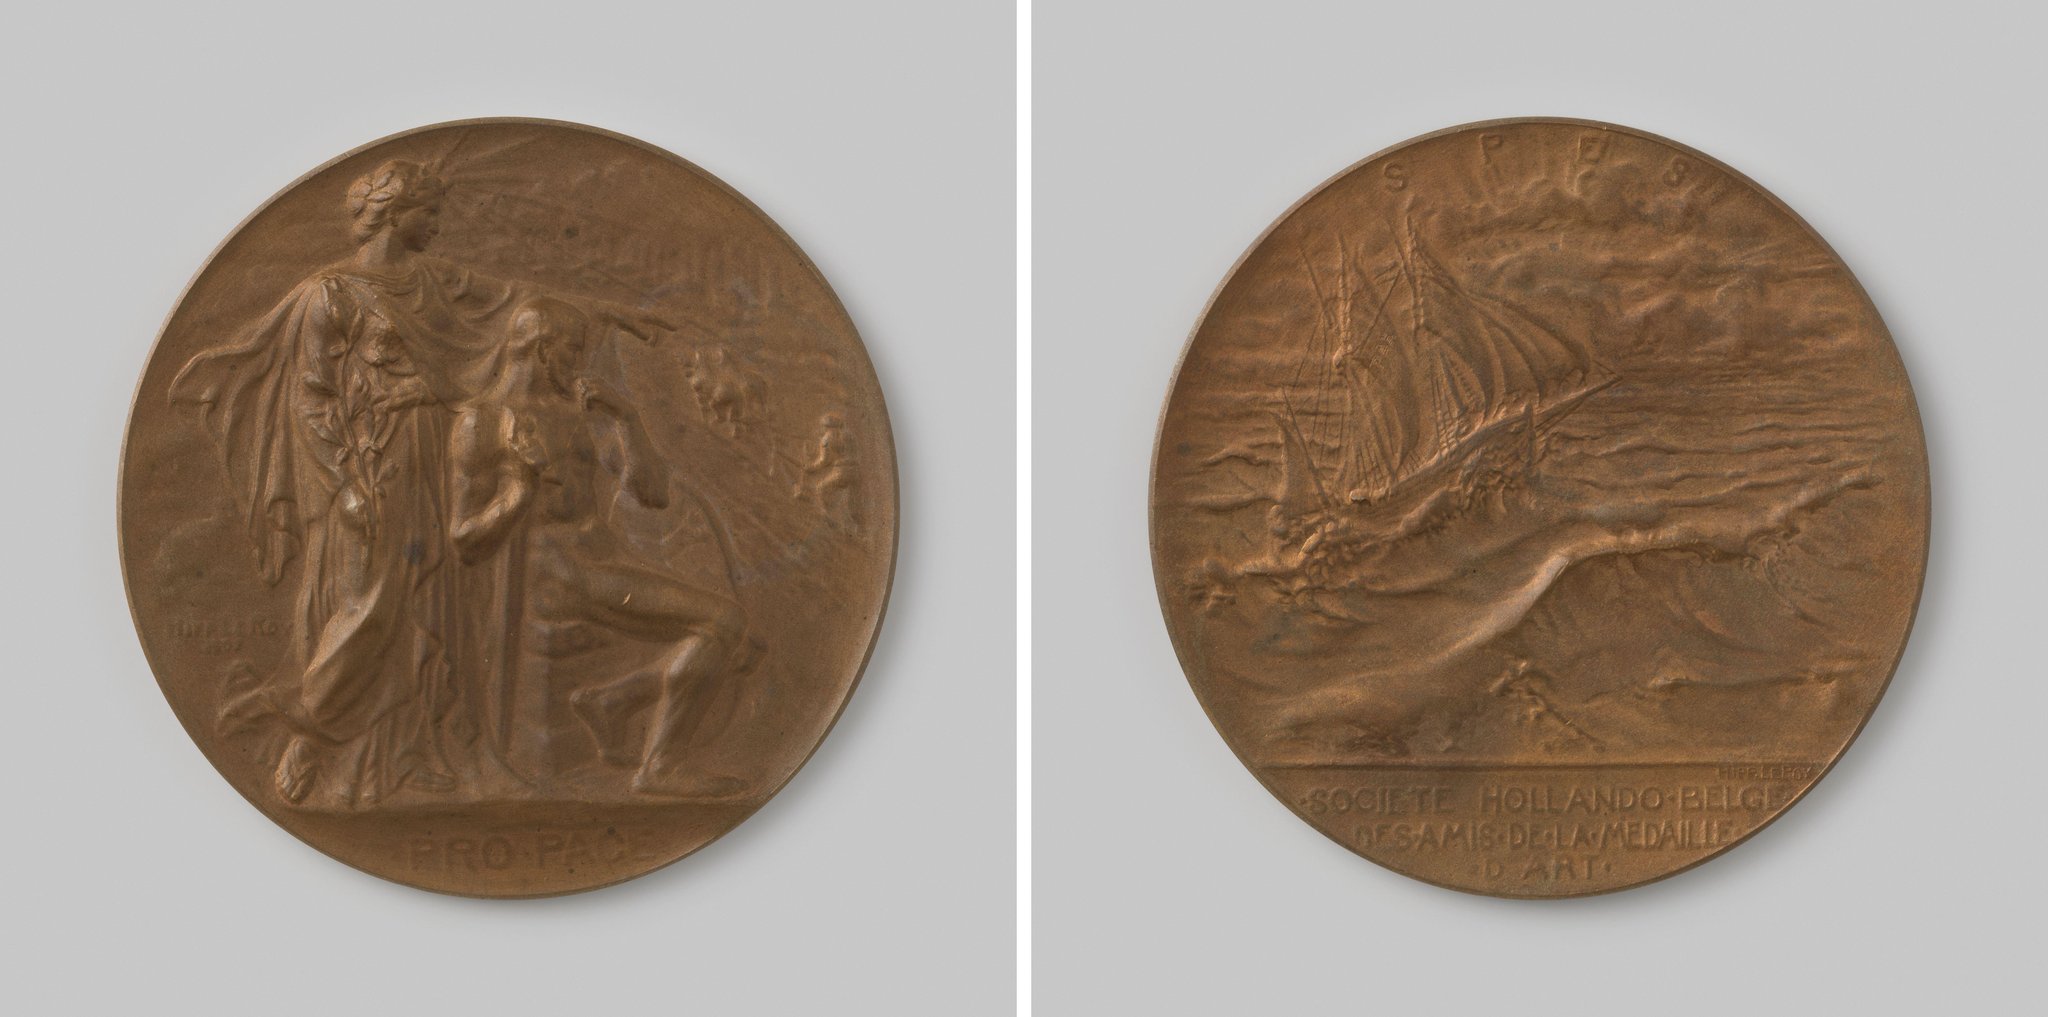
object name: history medal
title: Hoop op vrede (1907)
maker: hippolyte le roy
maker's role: modelleur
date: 1907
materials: bronze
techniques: striking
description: Bronzen penning, op de voorzijde een schip op woelige baren met omschrift en afsnedetekst, op de keerzijde een vrouw die een zittende man met zwaard wijst op een ploegende boer, met afsnedetekst.